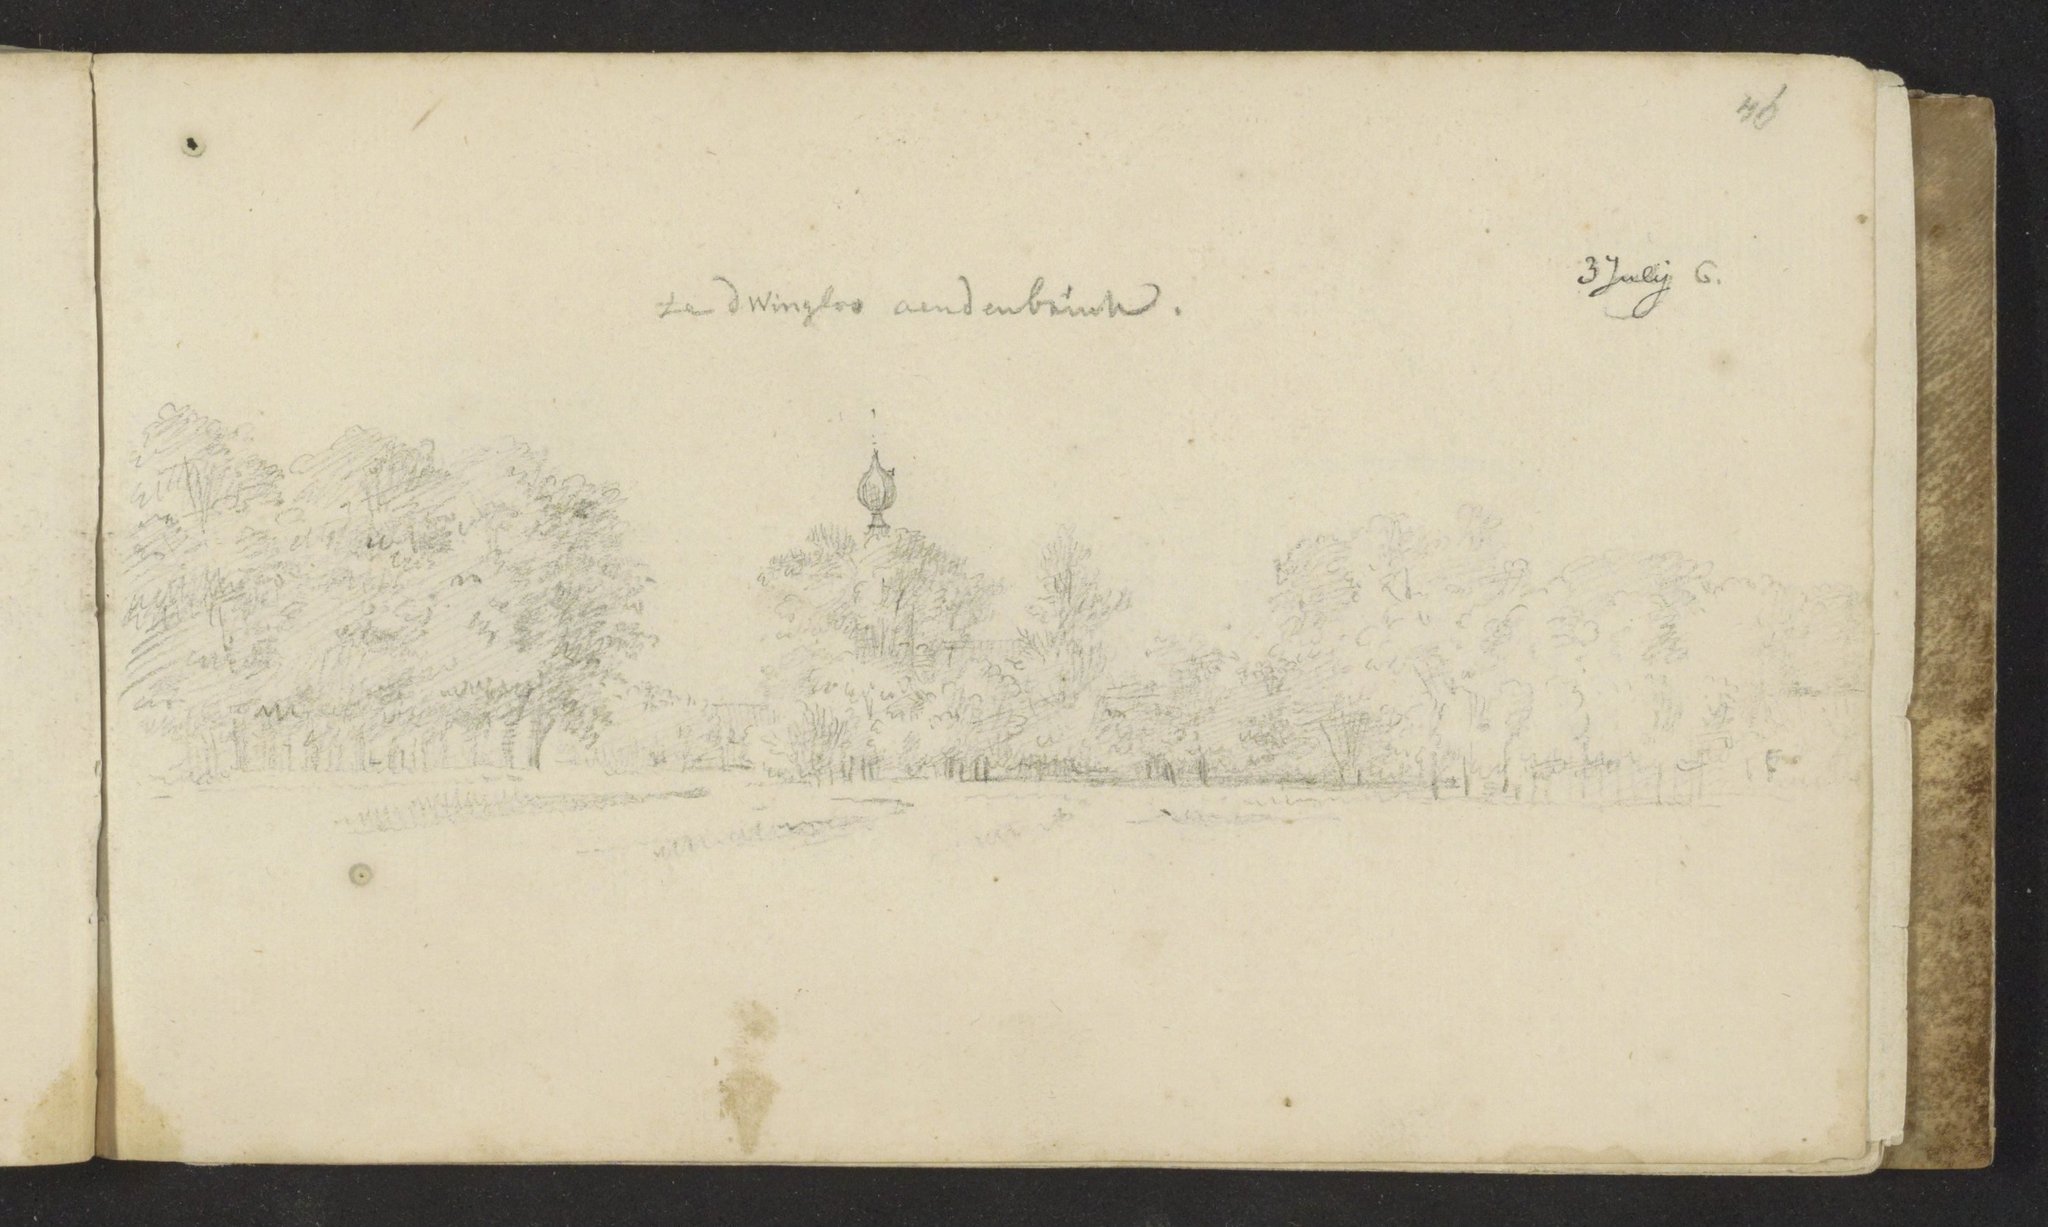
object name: sketchbook leaf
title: De Brink te Dwingeloo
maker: abraham de haen (ii)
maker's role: draughtsman, print maker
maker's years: 1707-1748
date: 1732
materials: paper, pencil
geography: dwingeloo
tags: public road in village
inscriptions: date and inscription: ‘te dwingloo aandenbrink/ 3 Julij’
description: Blad 46 recto uit een schetsboek met 51 bladen.